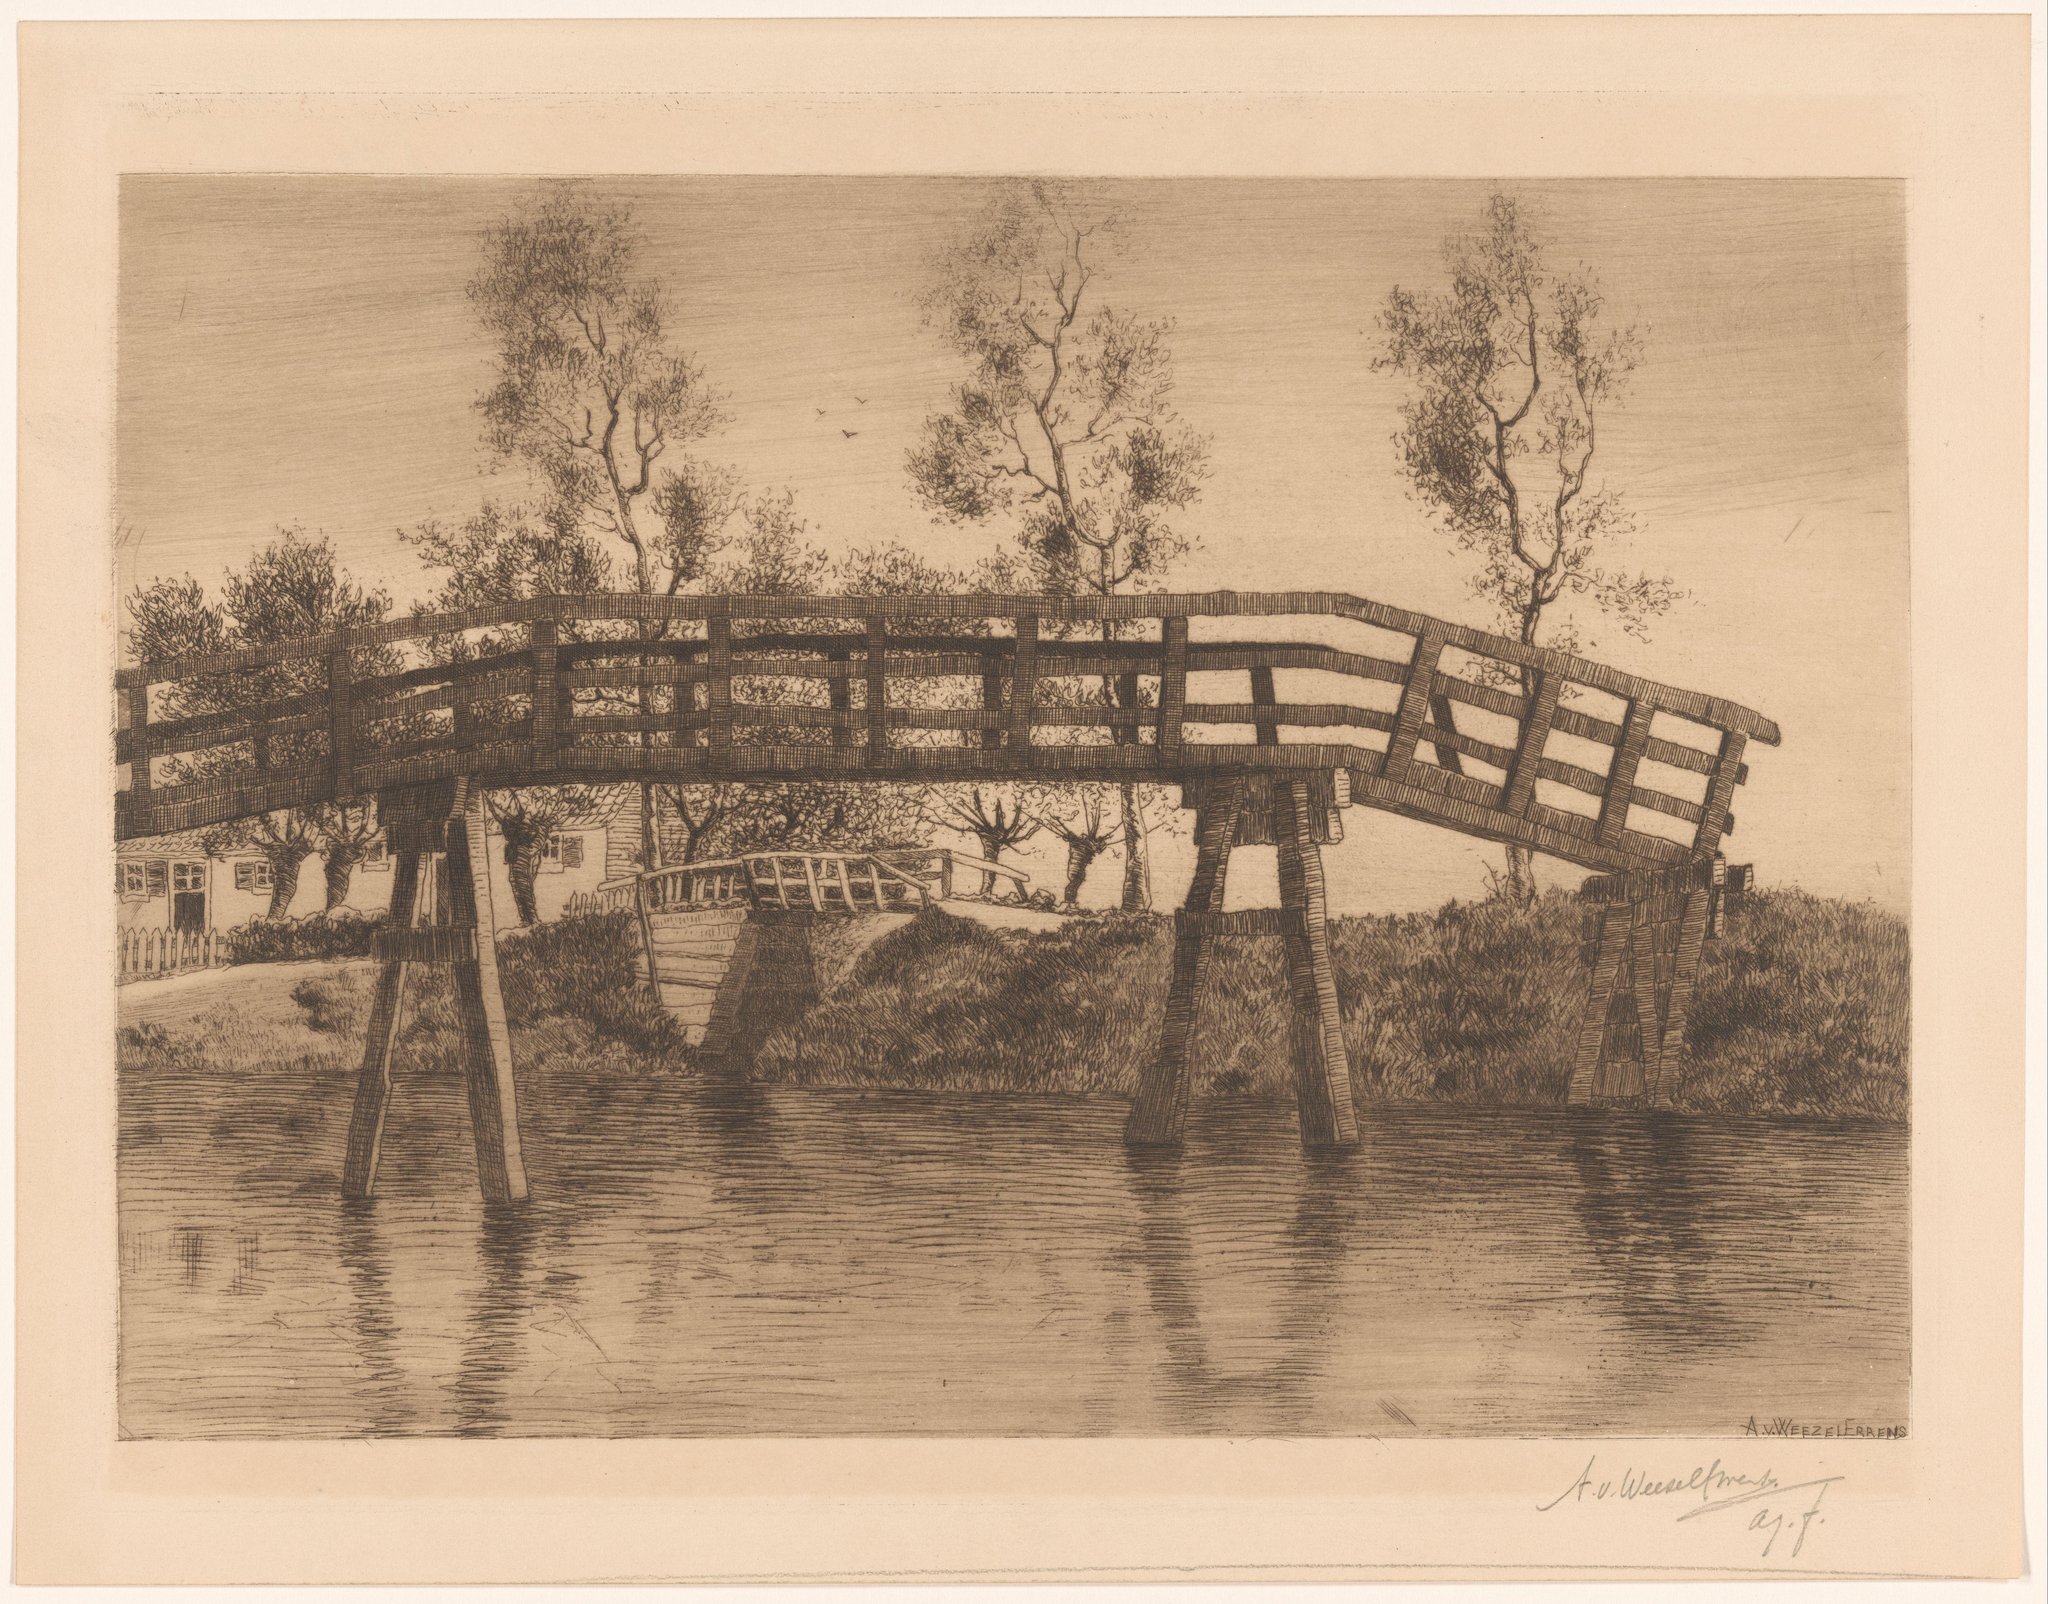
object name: print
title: Brugje (II)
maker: adolphe p.h j. van weezel errens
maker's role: print maker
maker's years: 1866-1939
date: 1876-1912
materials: paper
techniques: etching, intaglio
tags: bridge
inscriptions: collector's mark: Lugt 2760, collector's mark: Lugt 2228, inscription: ‘p/a ƒ 15,-’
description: Brug in een landschap met rechtsachter een huis.